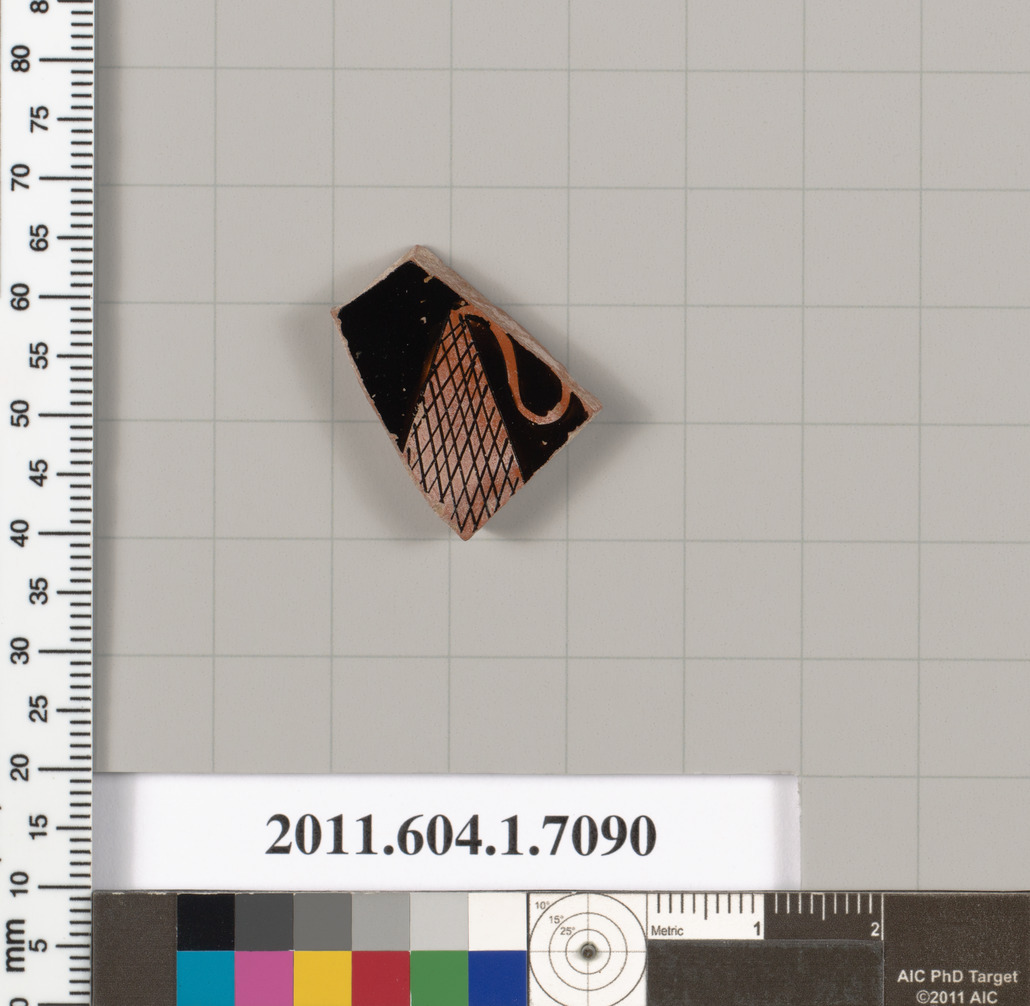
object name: kylix fragment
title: Terracotta fragment of a kylix (drinking cup)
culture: greek, attic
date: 500-480 BCE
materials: terracotta